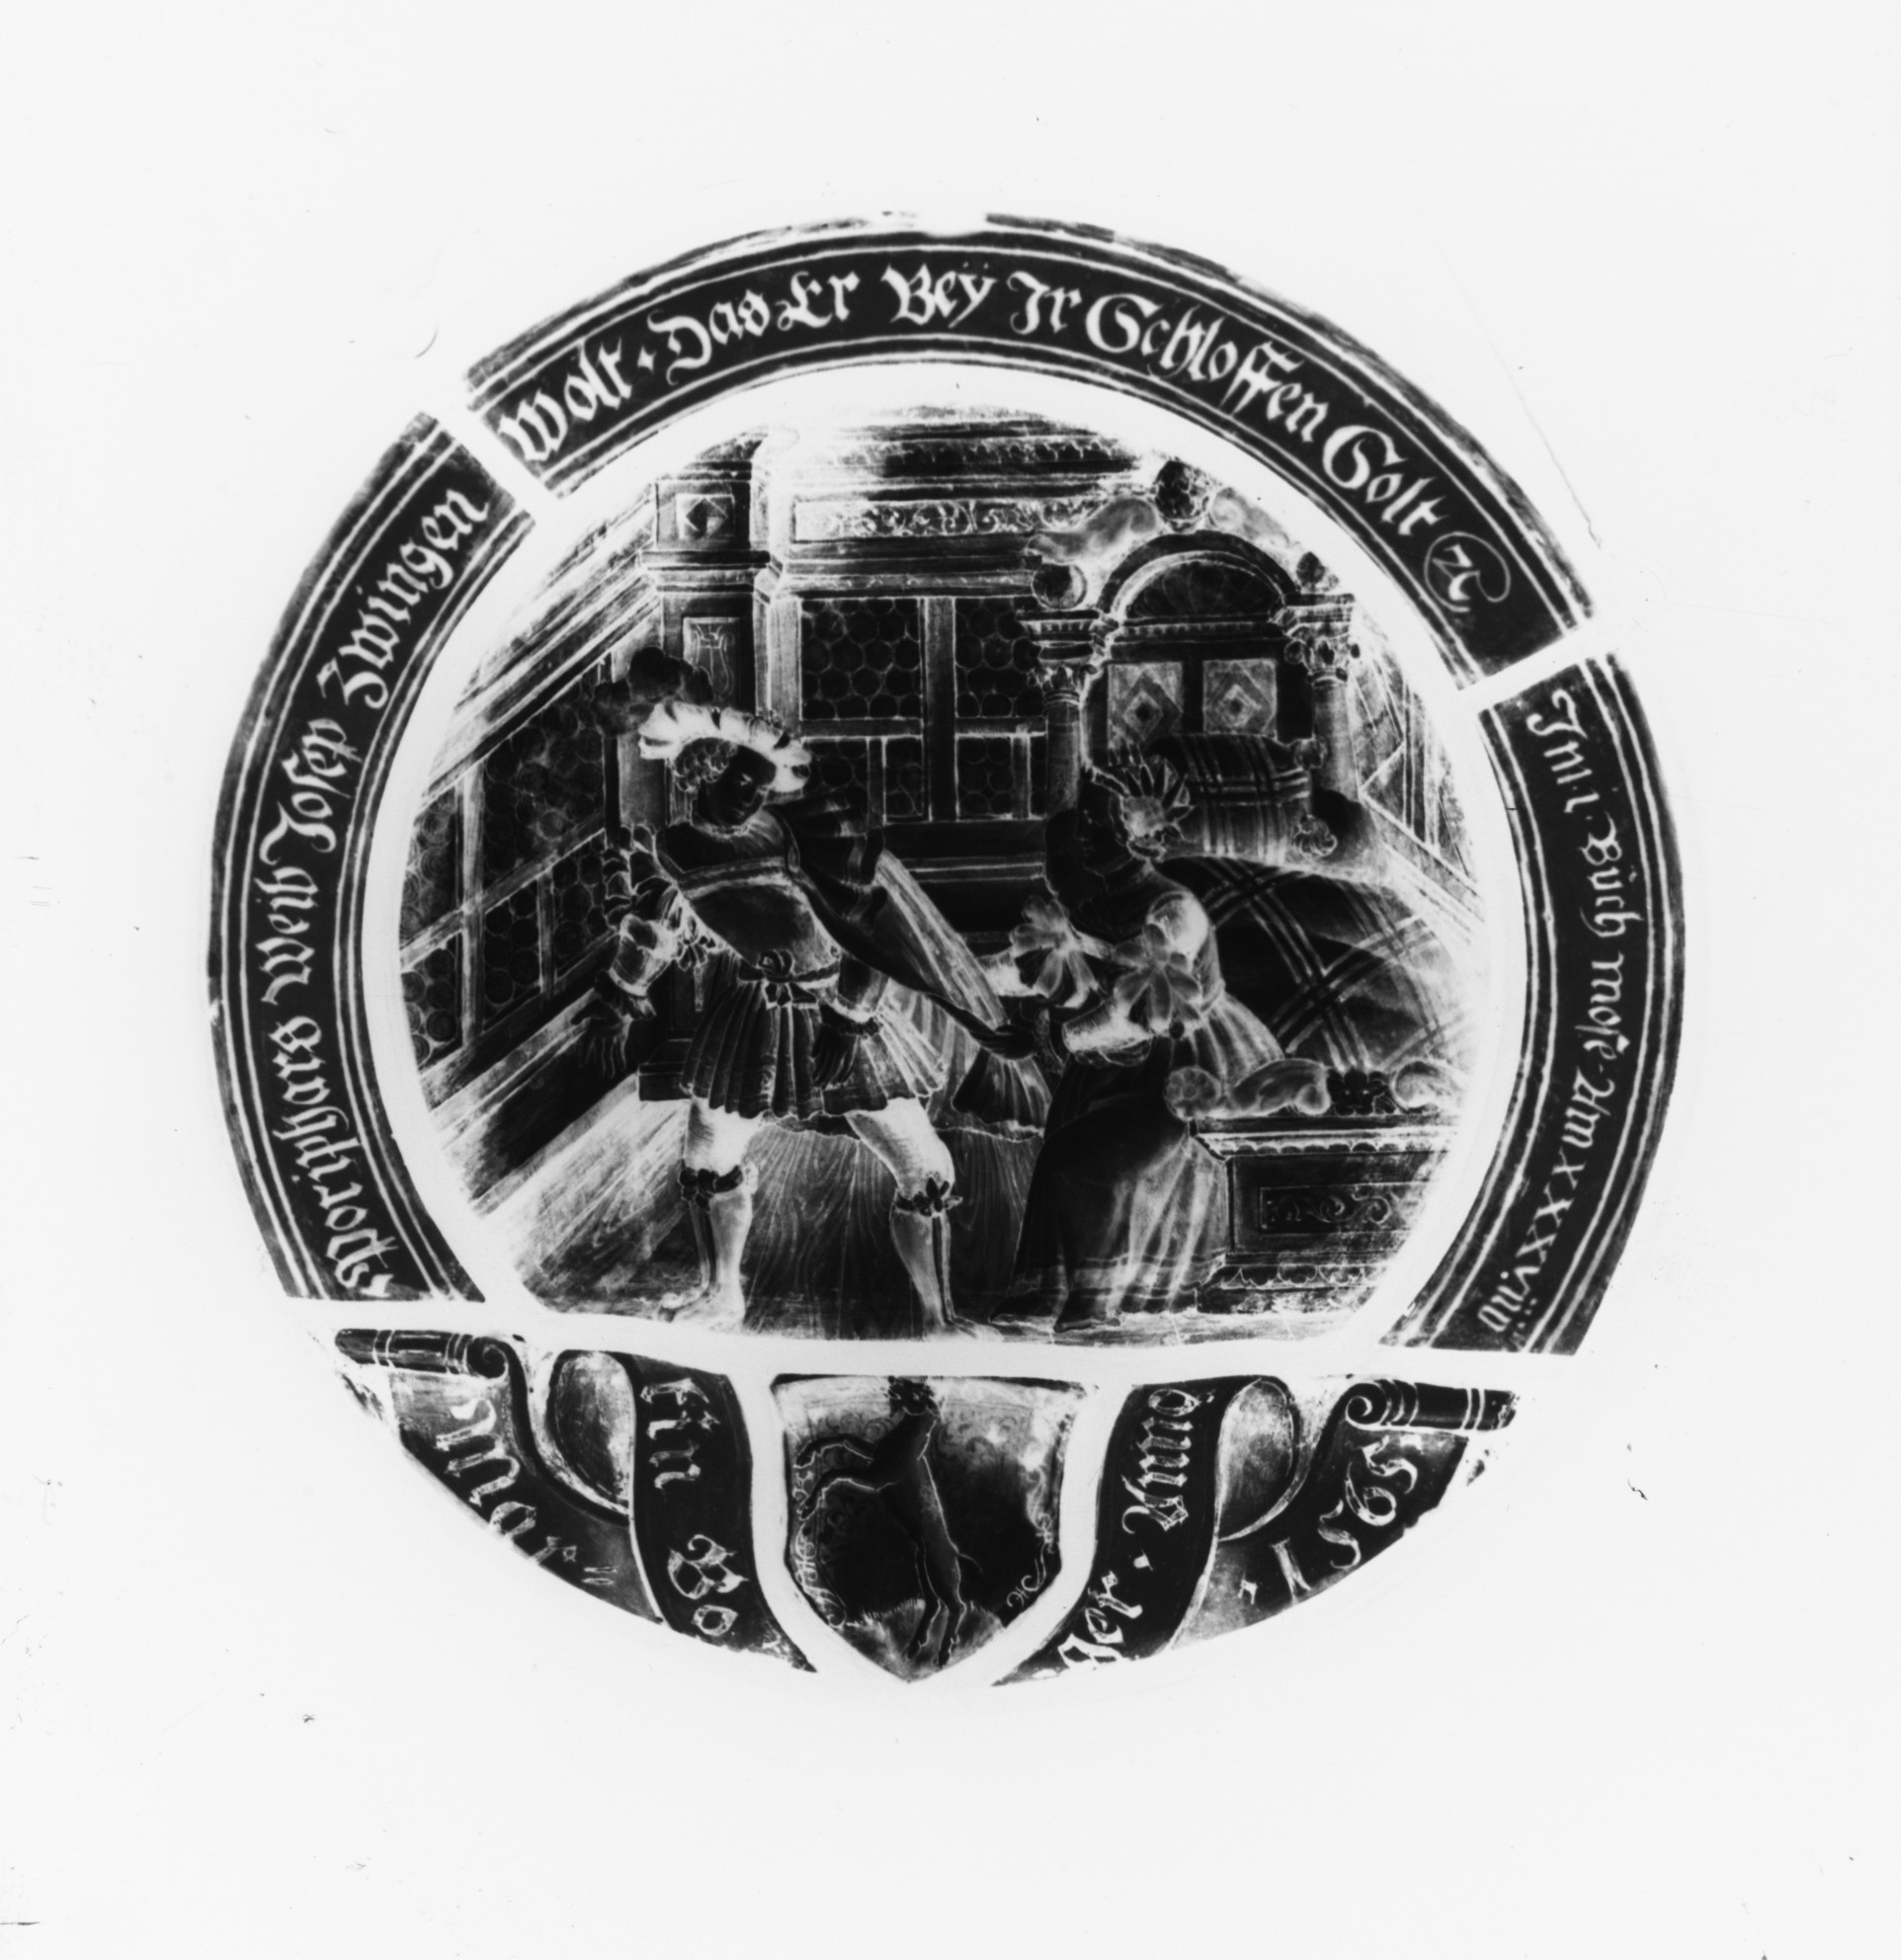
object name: roundel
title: Joseph Leaving Potiphar's Wife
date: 1501-1600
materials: glass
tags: animals,men,women